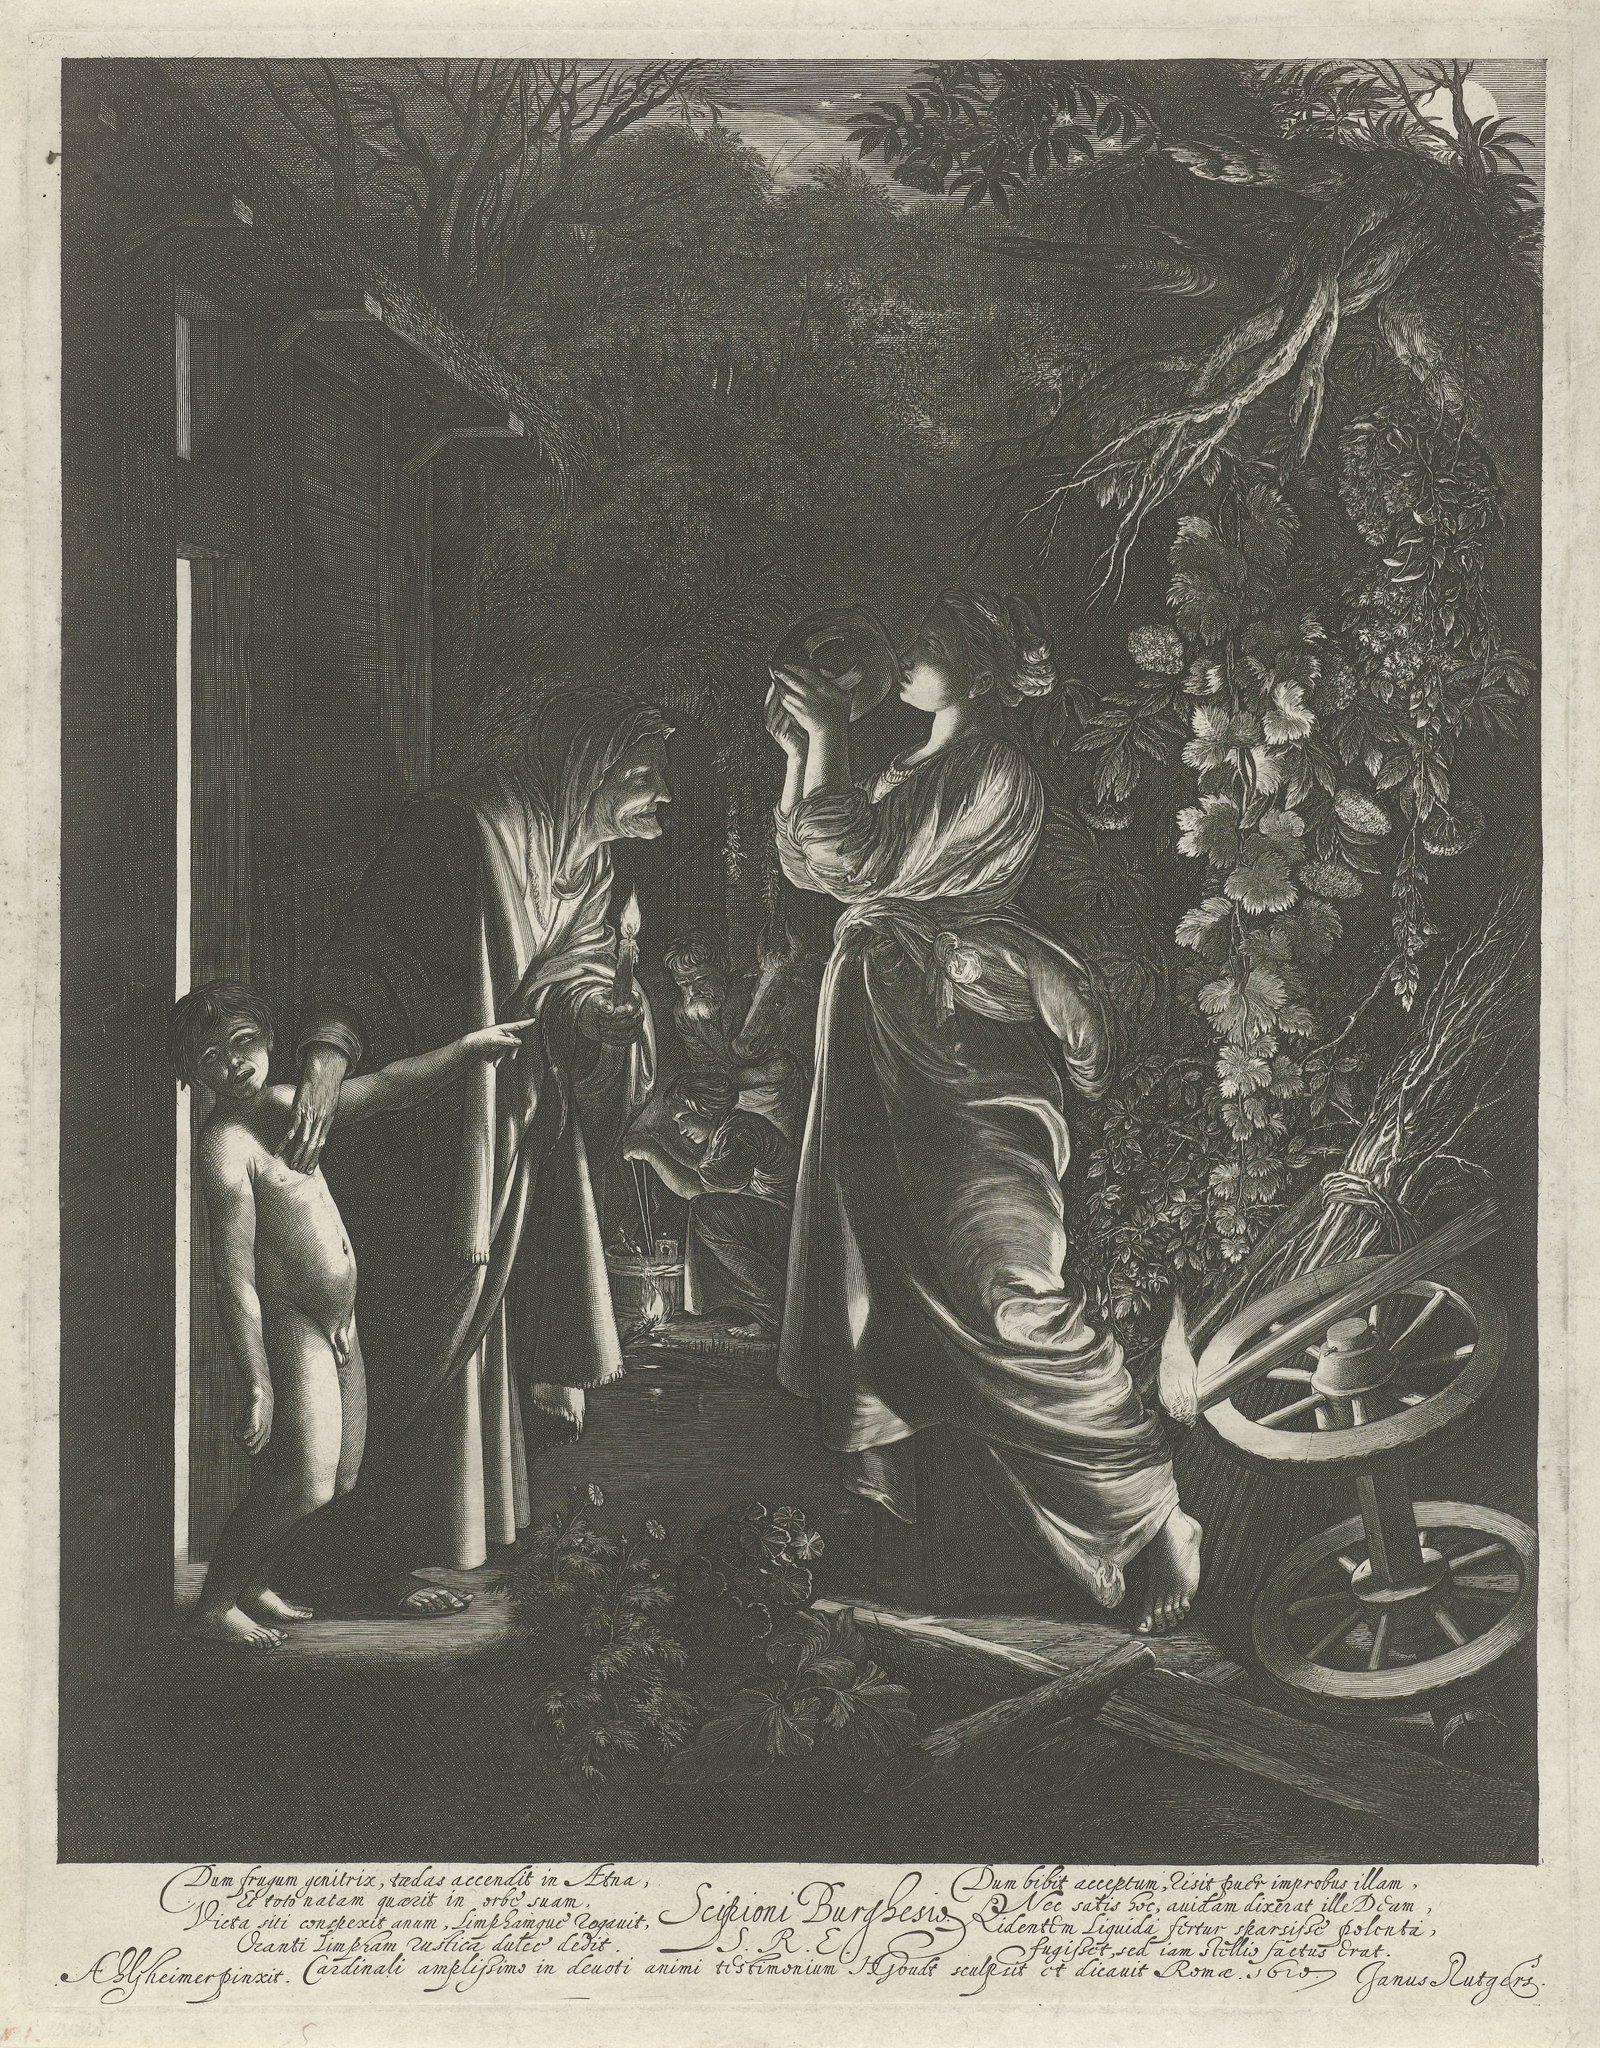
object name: print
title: Bespotting van Ceres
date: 1610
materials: paper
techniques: engraving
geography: rome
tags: a little boy (abas, ascalabus, or stellio) laughs at ceres, because she drinks too avidly while she is resting at an old woman's house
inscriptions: number: ‘161’, number: ‘N. 1’, collector's mark: Lugt 2760, collector's mark: Lugt 2228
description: De godin Ceres, op zoek naar haar dochter Proserpina, rust uit bij een hut. Ze drinkt uit een kruik, gegeven aan haar door een oude vrouw. Een kleine naakte jongen naast de oude vrouw wijst naar Ceres en lacht haar uit. De prent heeft een Latijns onderschrift. Naar een schilderij van Adam Elsheimer.